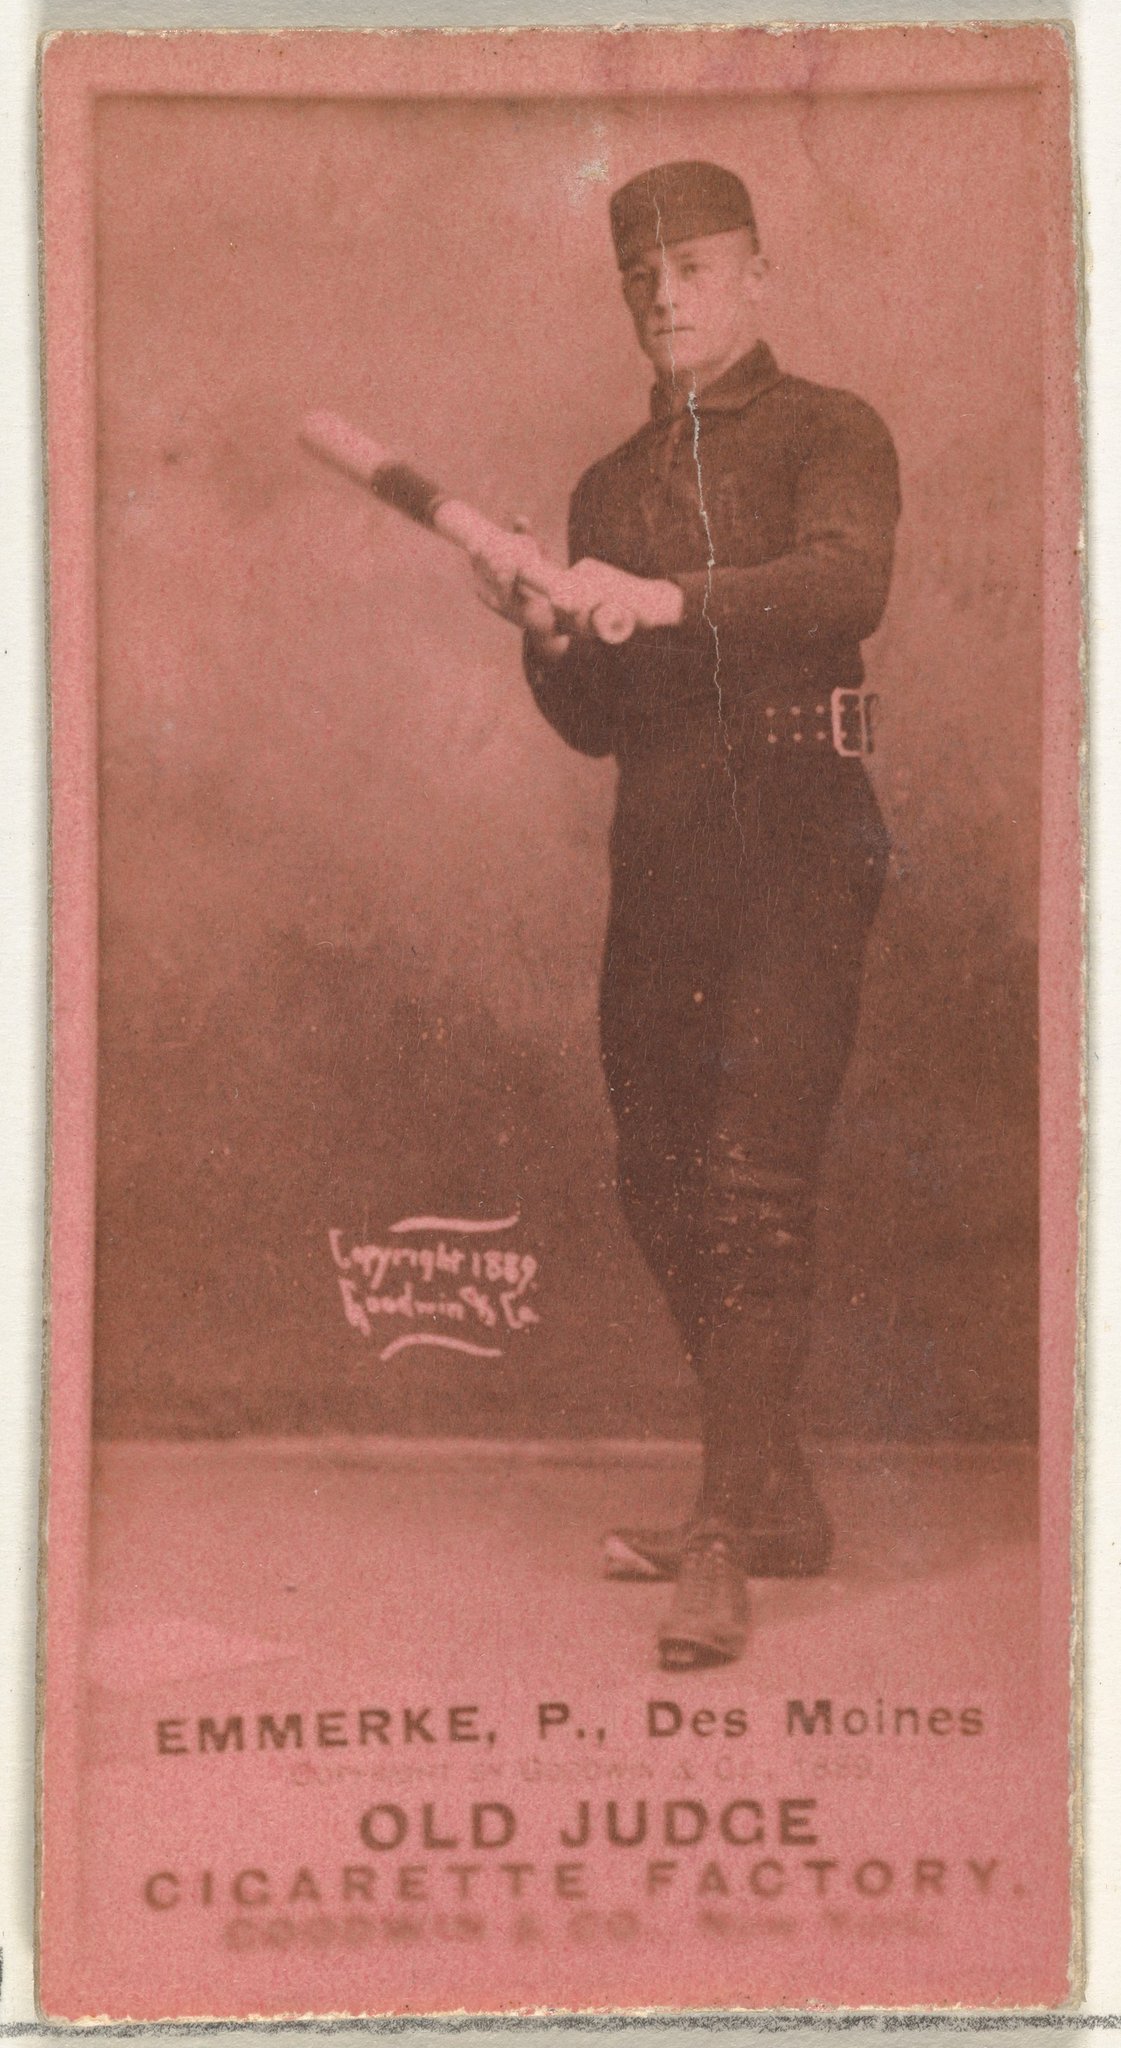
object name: baseball card, photograph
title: Robert Emmerke, Pitcher, Des Moines Prohibitionists, from the Old Judge series (N172) for Old Judge Cigarettes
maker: goodwin & company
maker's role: publisher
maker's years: 1850-1950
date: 1889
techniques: albumen silver print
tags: men,portraits,baseball,athletes